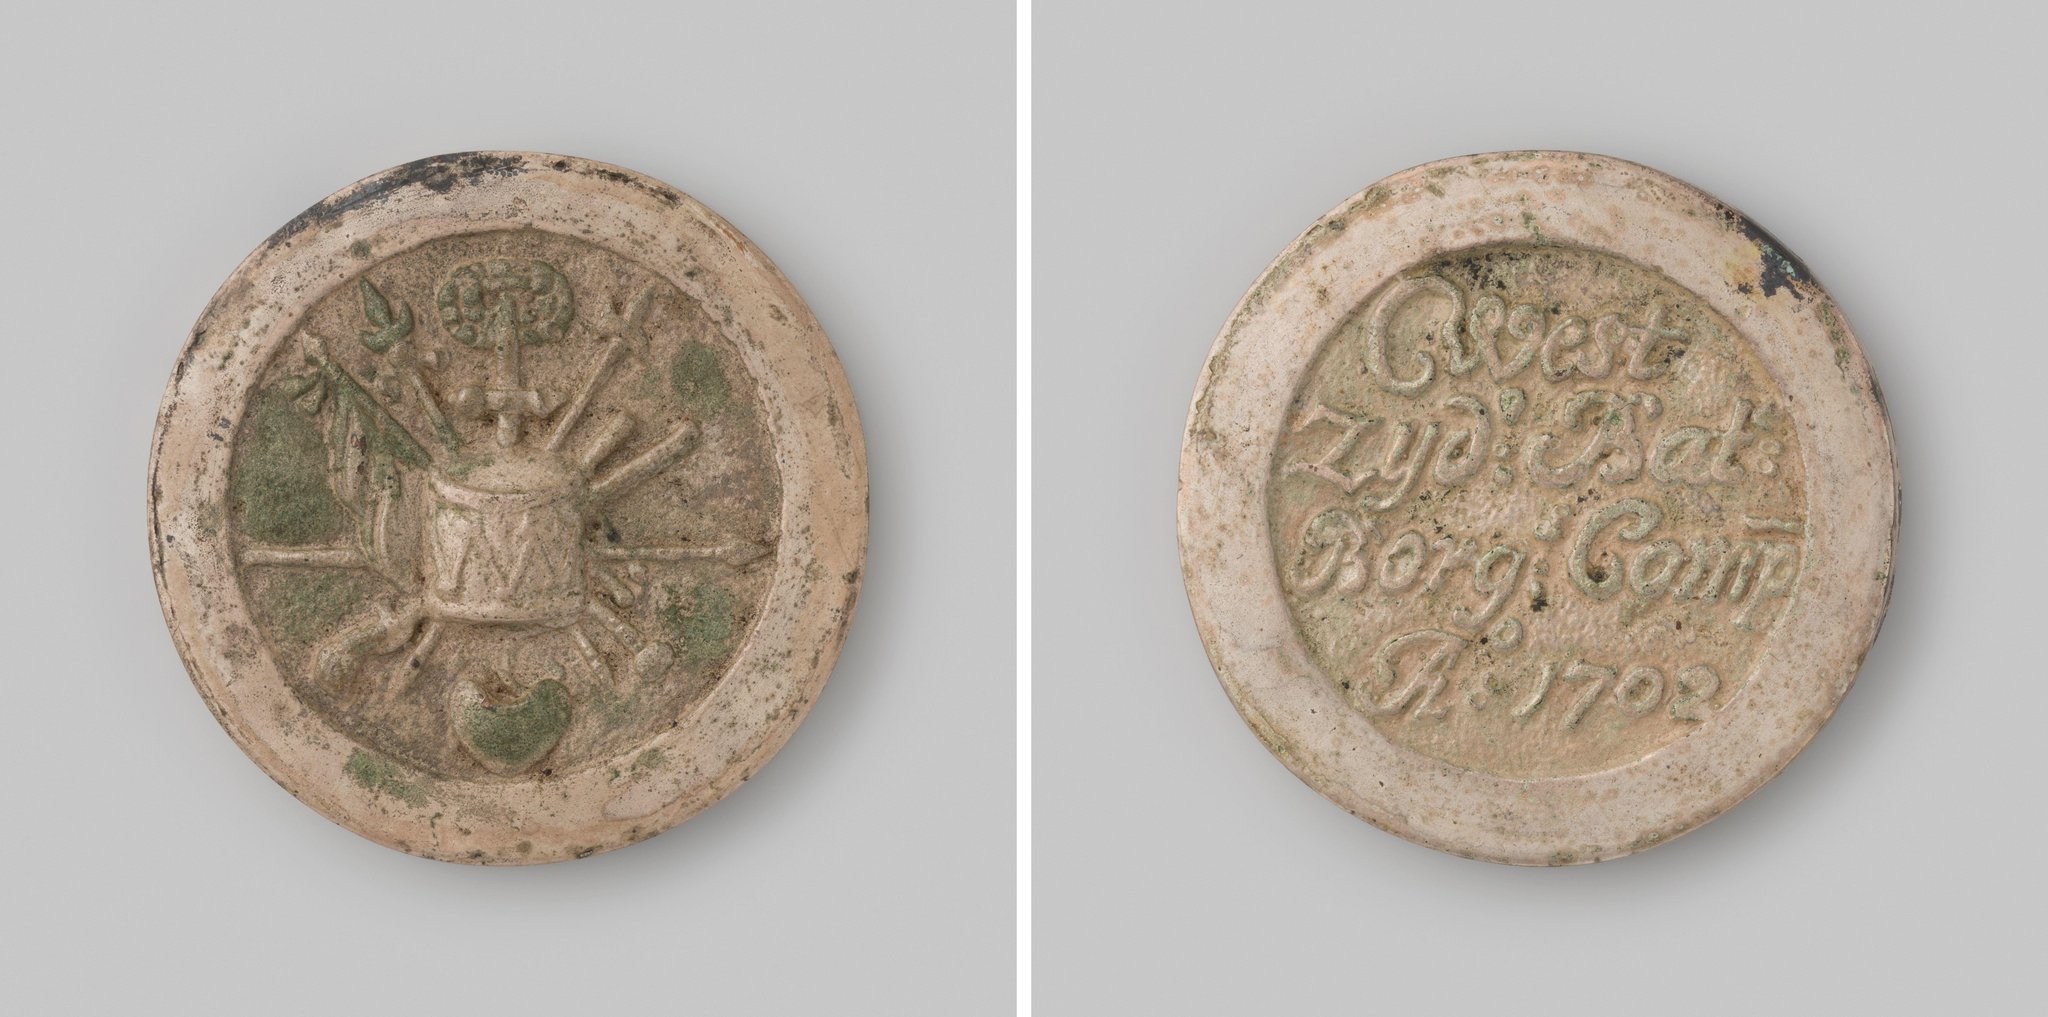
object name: history medal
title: Penning der Westzijde Borger Compagnie te Batavia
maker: Anonymous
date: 1702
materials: copper, silver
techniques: silvering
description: Verzilverde koperen penning. Reproductie. Voorzijde: trom met vaandel, pieken, handbus, lans en trofee. Daaronder een ringkraag en bovenaan een degen met de punt door een lauwerkrans (het wapen van Batavia). Keerzijde: West/ zijde Bate/ Borgr Comp/ A° 1702.